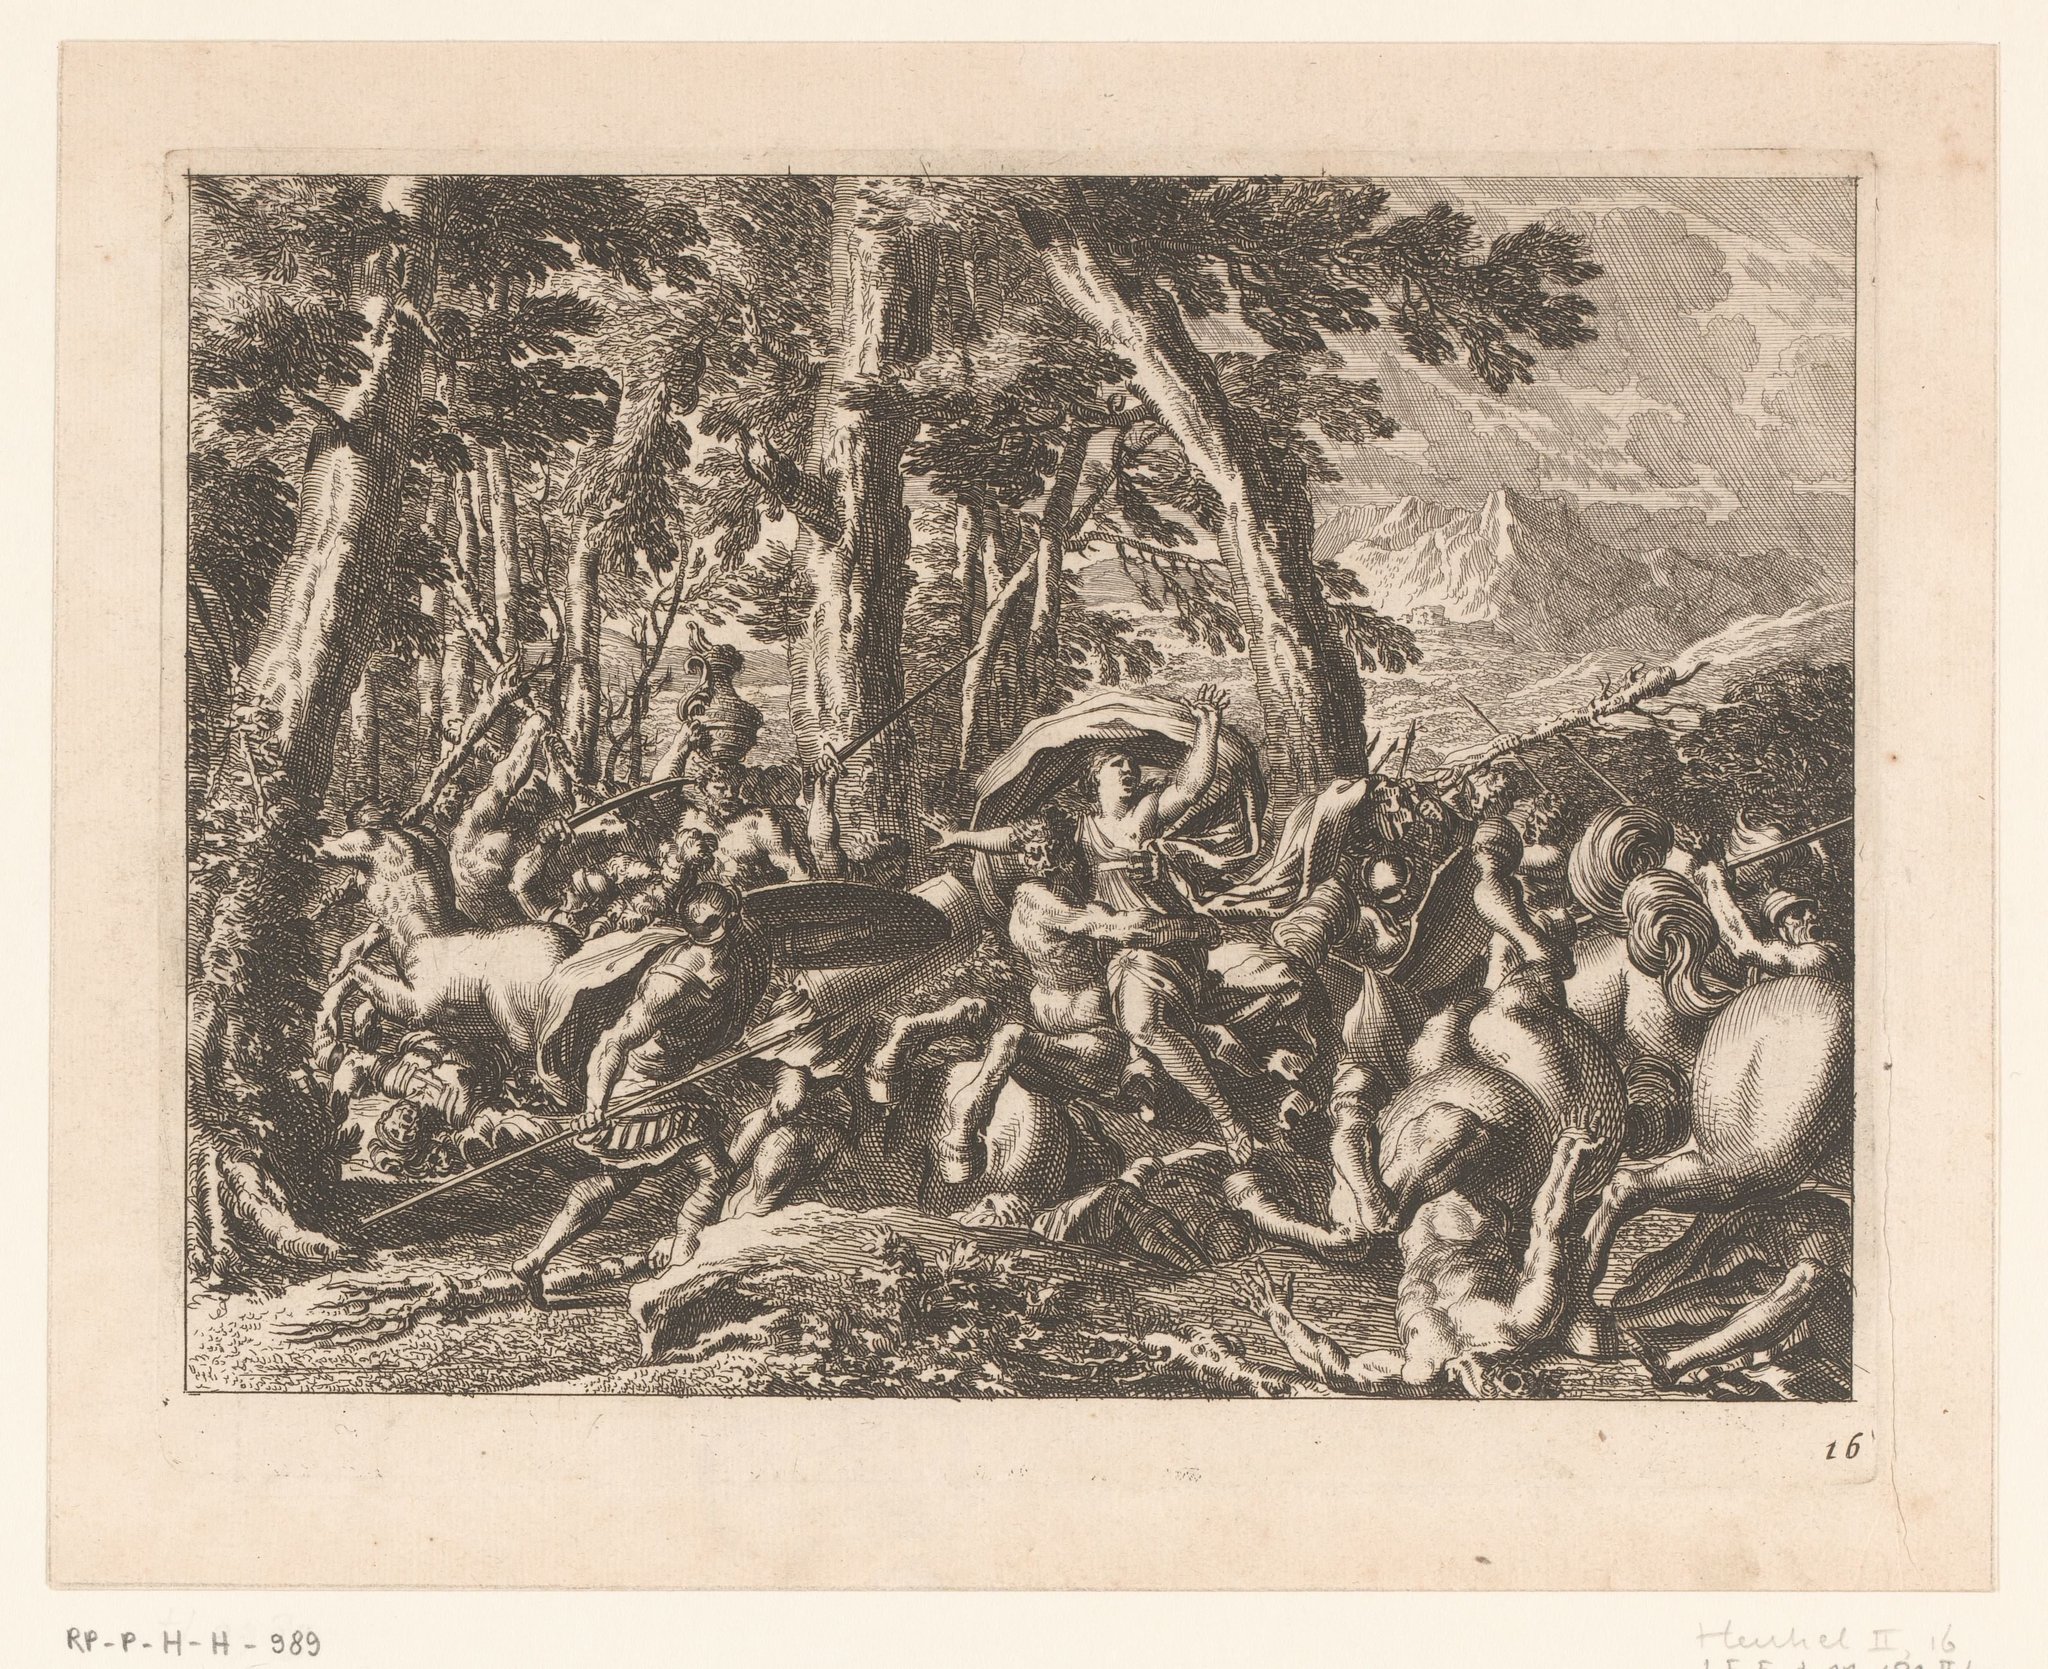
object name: print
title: Mythologische scènes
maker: jean lepautre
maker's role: draughtsman, print maker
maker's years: 1618-1682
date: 1628-1682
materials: paper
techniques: etching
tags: fight of lapiths and centaurs at the wedding of pirithous and hippodamia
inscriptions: collector's mark: Lugt 11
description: Maakt deel uit van een twintigdelige serie met mythologische scènes.